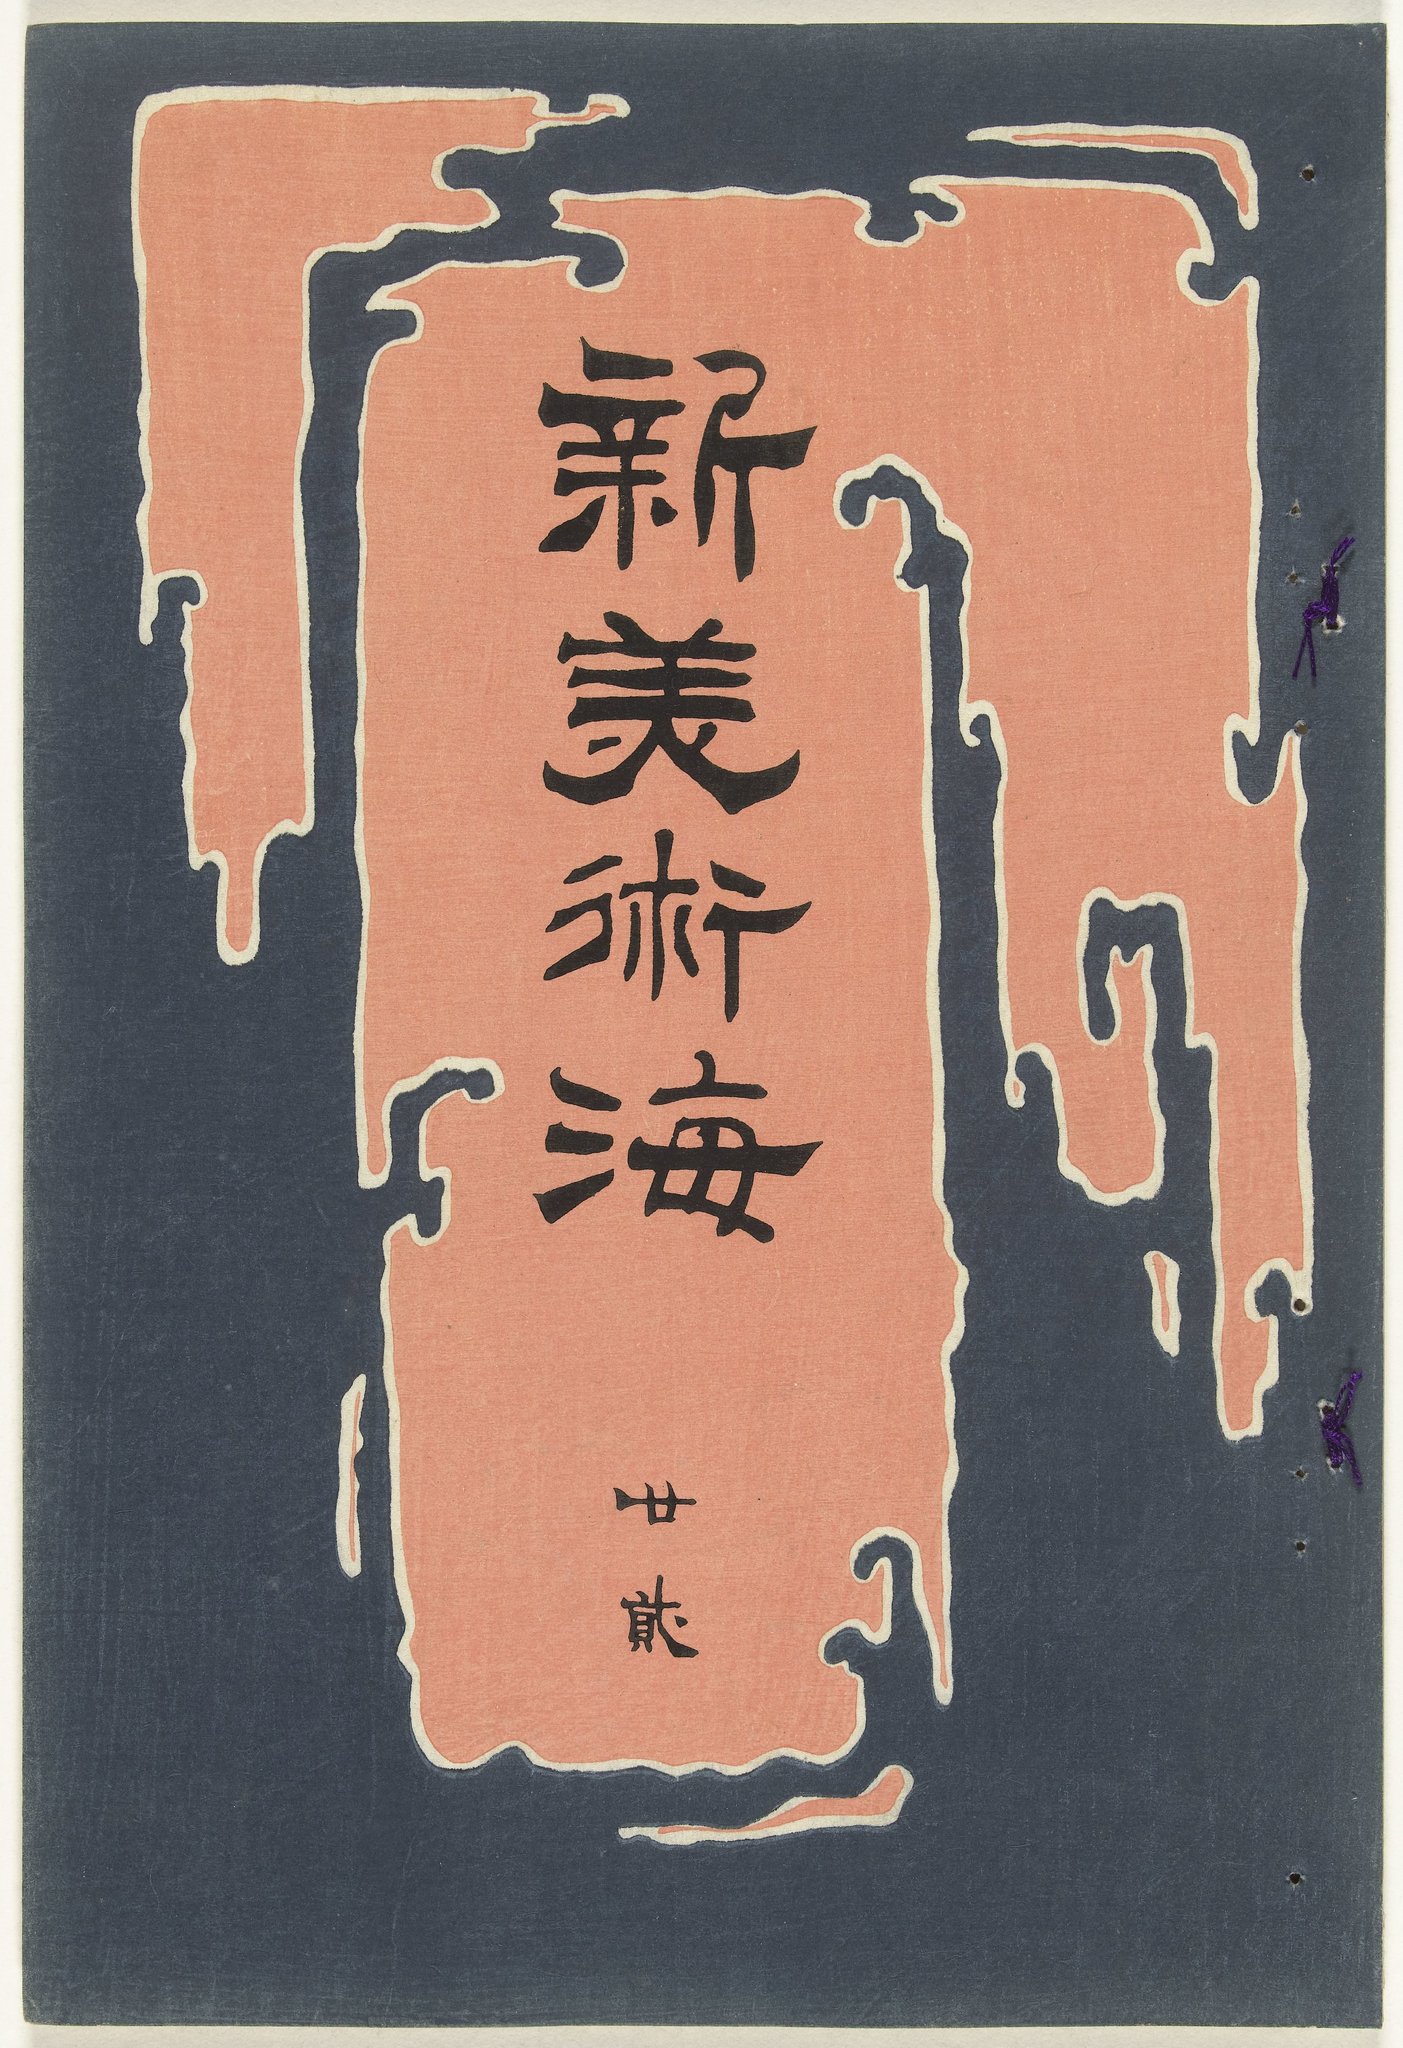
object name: book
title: Shin bijutsukai - nijuni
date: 1904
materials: gold powder, paper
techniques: woodcut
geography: kyoto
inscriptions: date